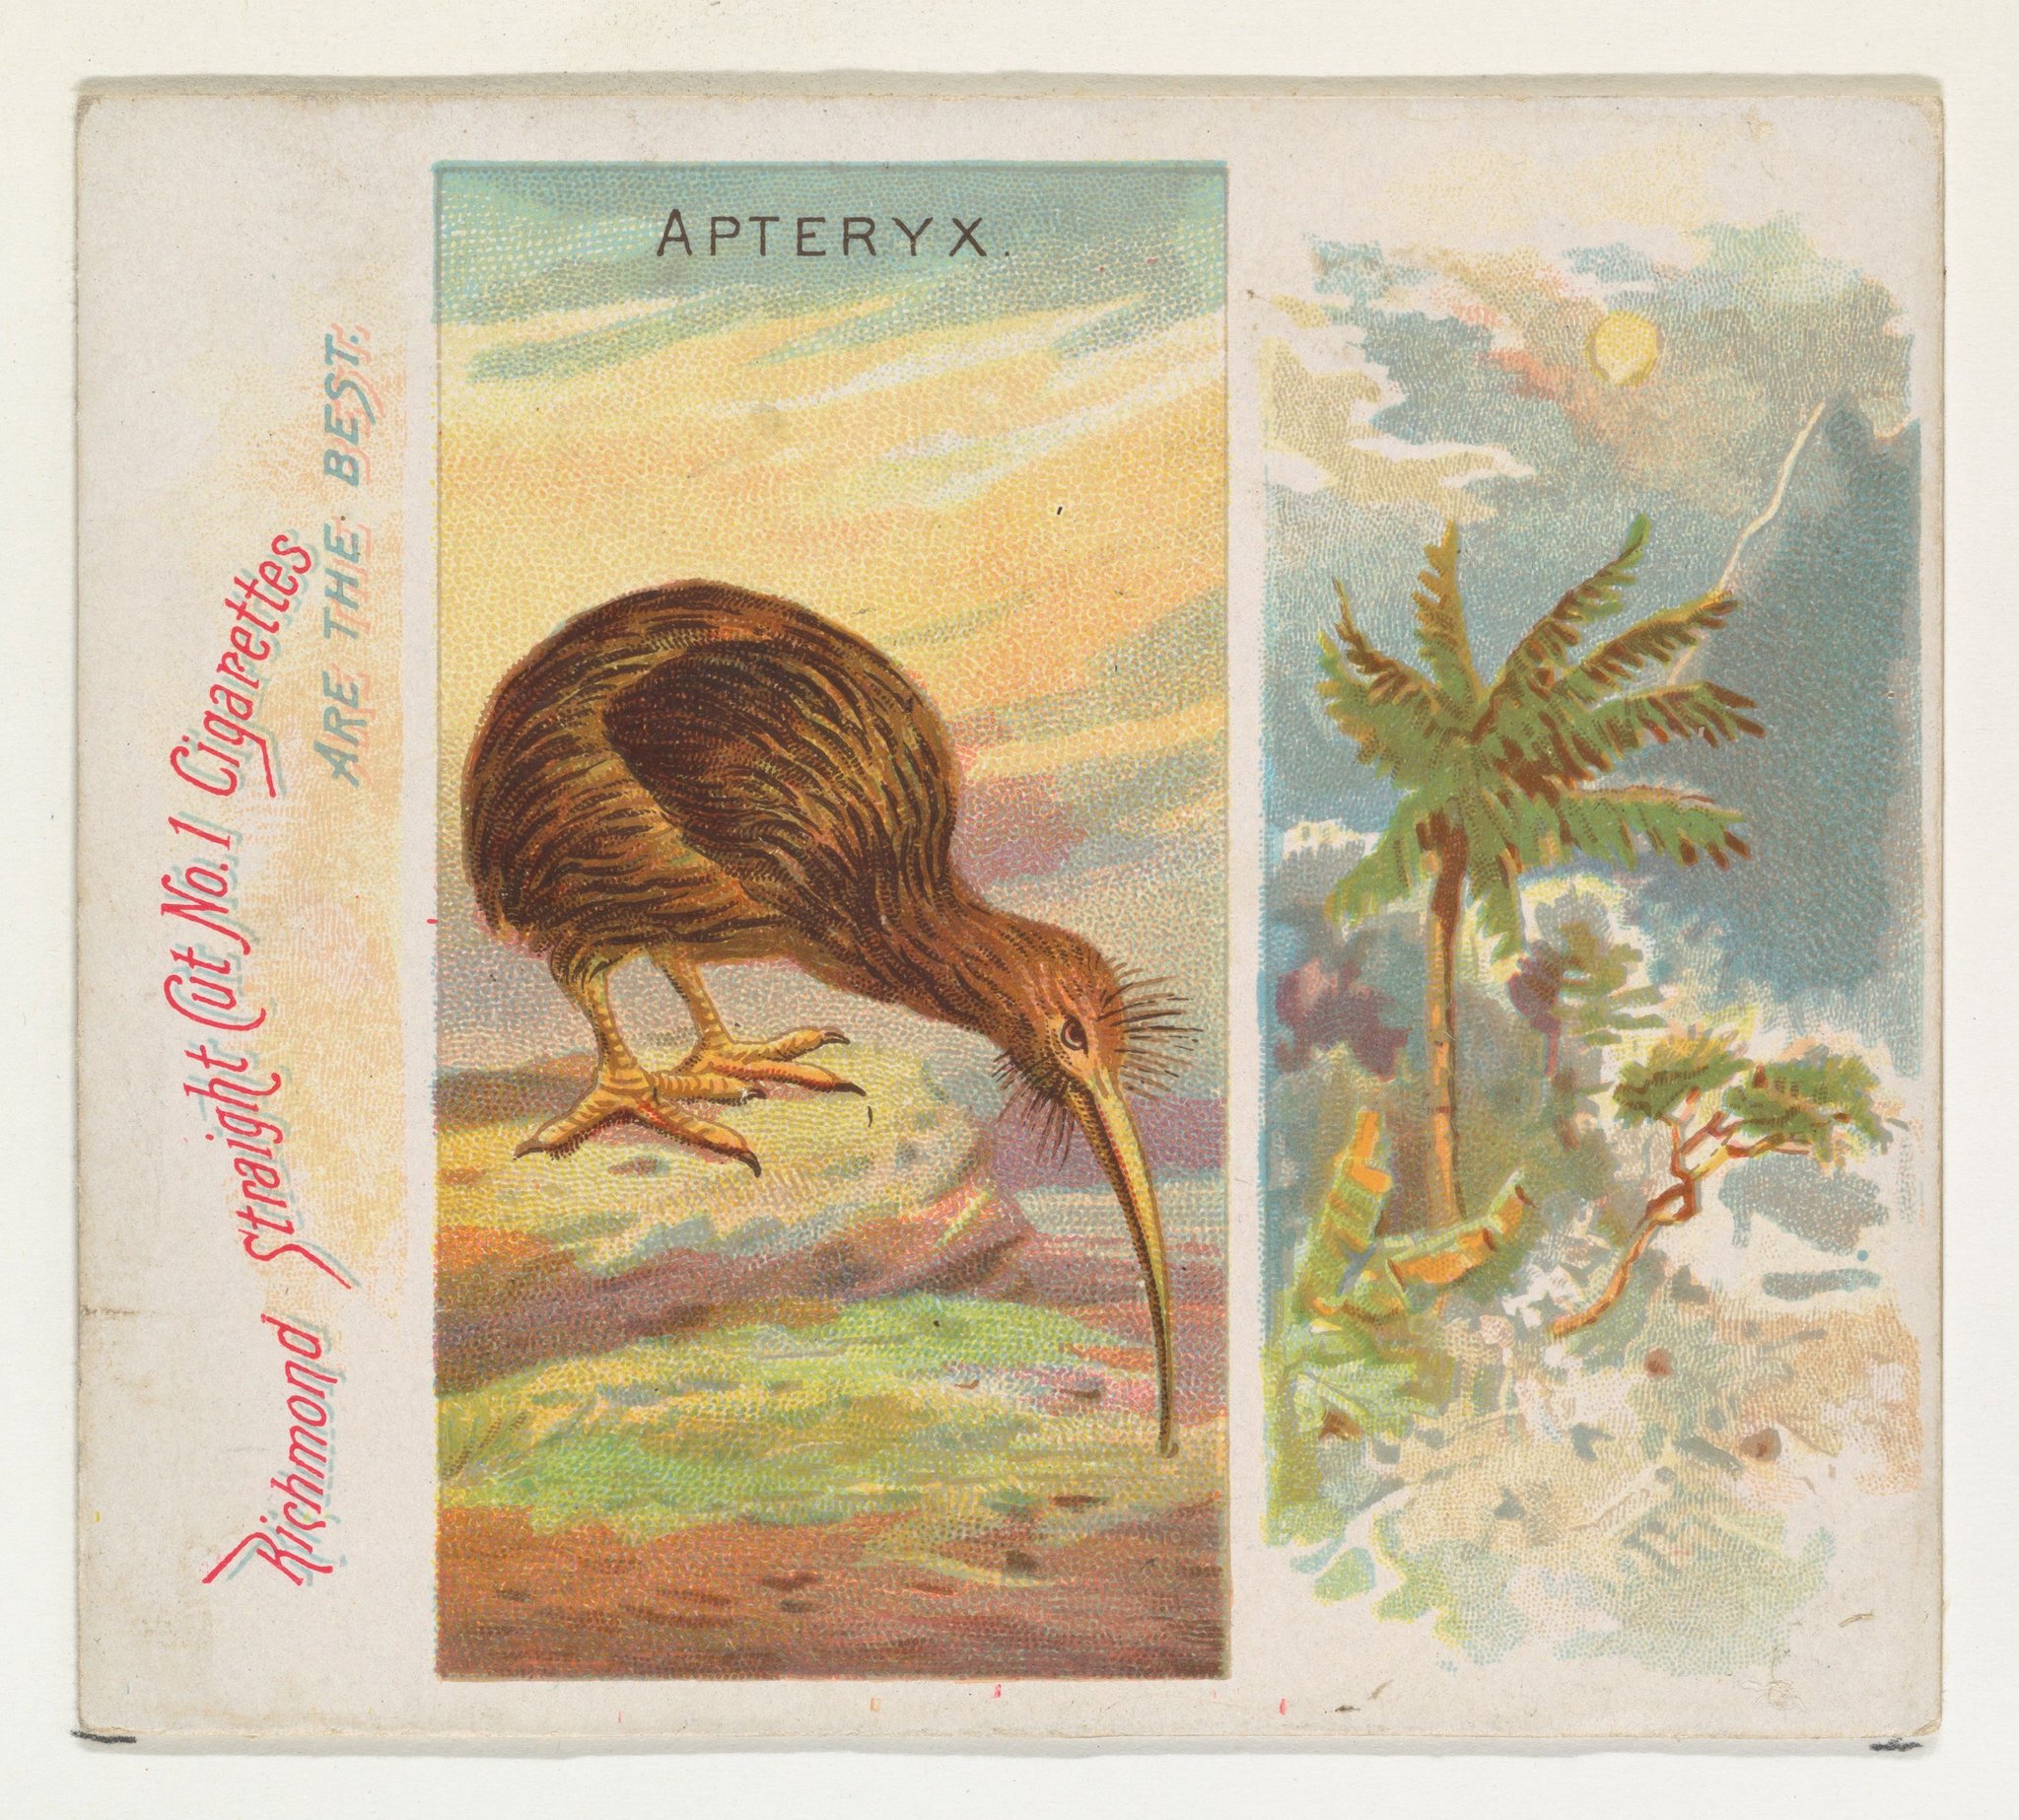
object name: print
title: Apteryx, from Birds of the Tropics series (N38) for Allen & Ginter Cigarettes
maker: allen & ginter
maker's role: publisher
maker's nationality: american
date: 1889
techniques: color lithograph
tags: birds